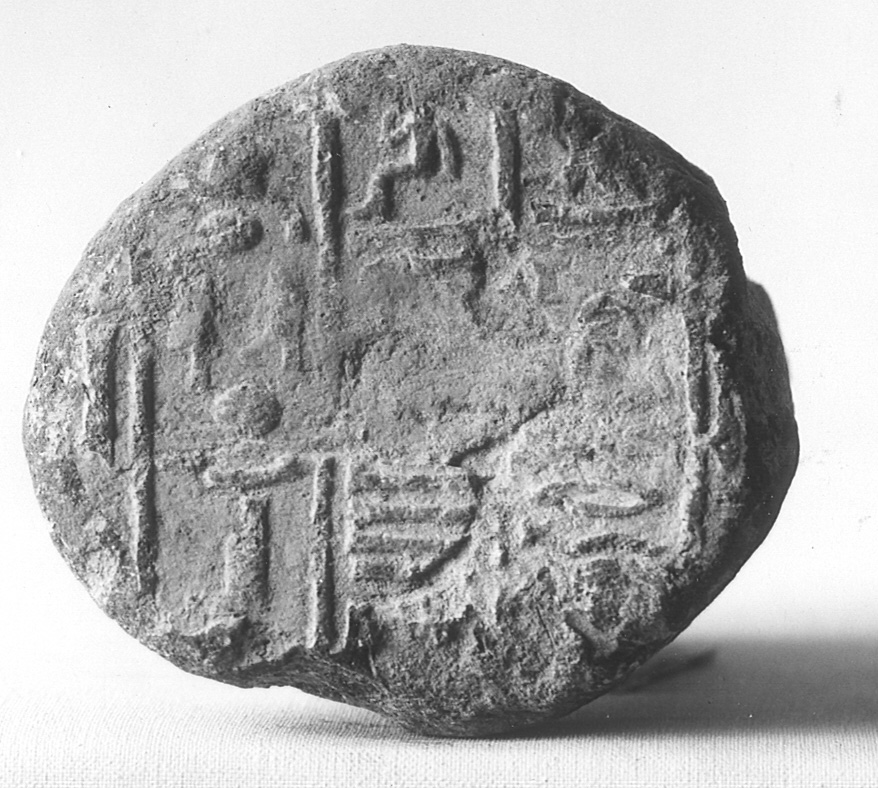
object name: cone, circular impression, nentaweref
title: Funerary Cone of Nentaweref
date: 1550-1352 BCE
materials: pottery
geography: egypt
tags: hieroglyphs